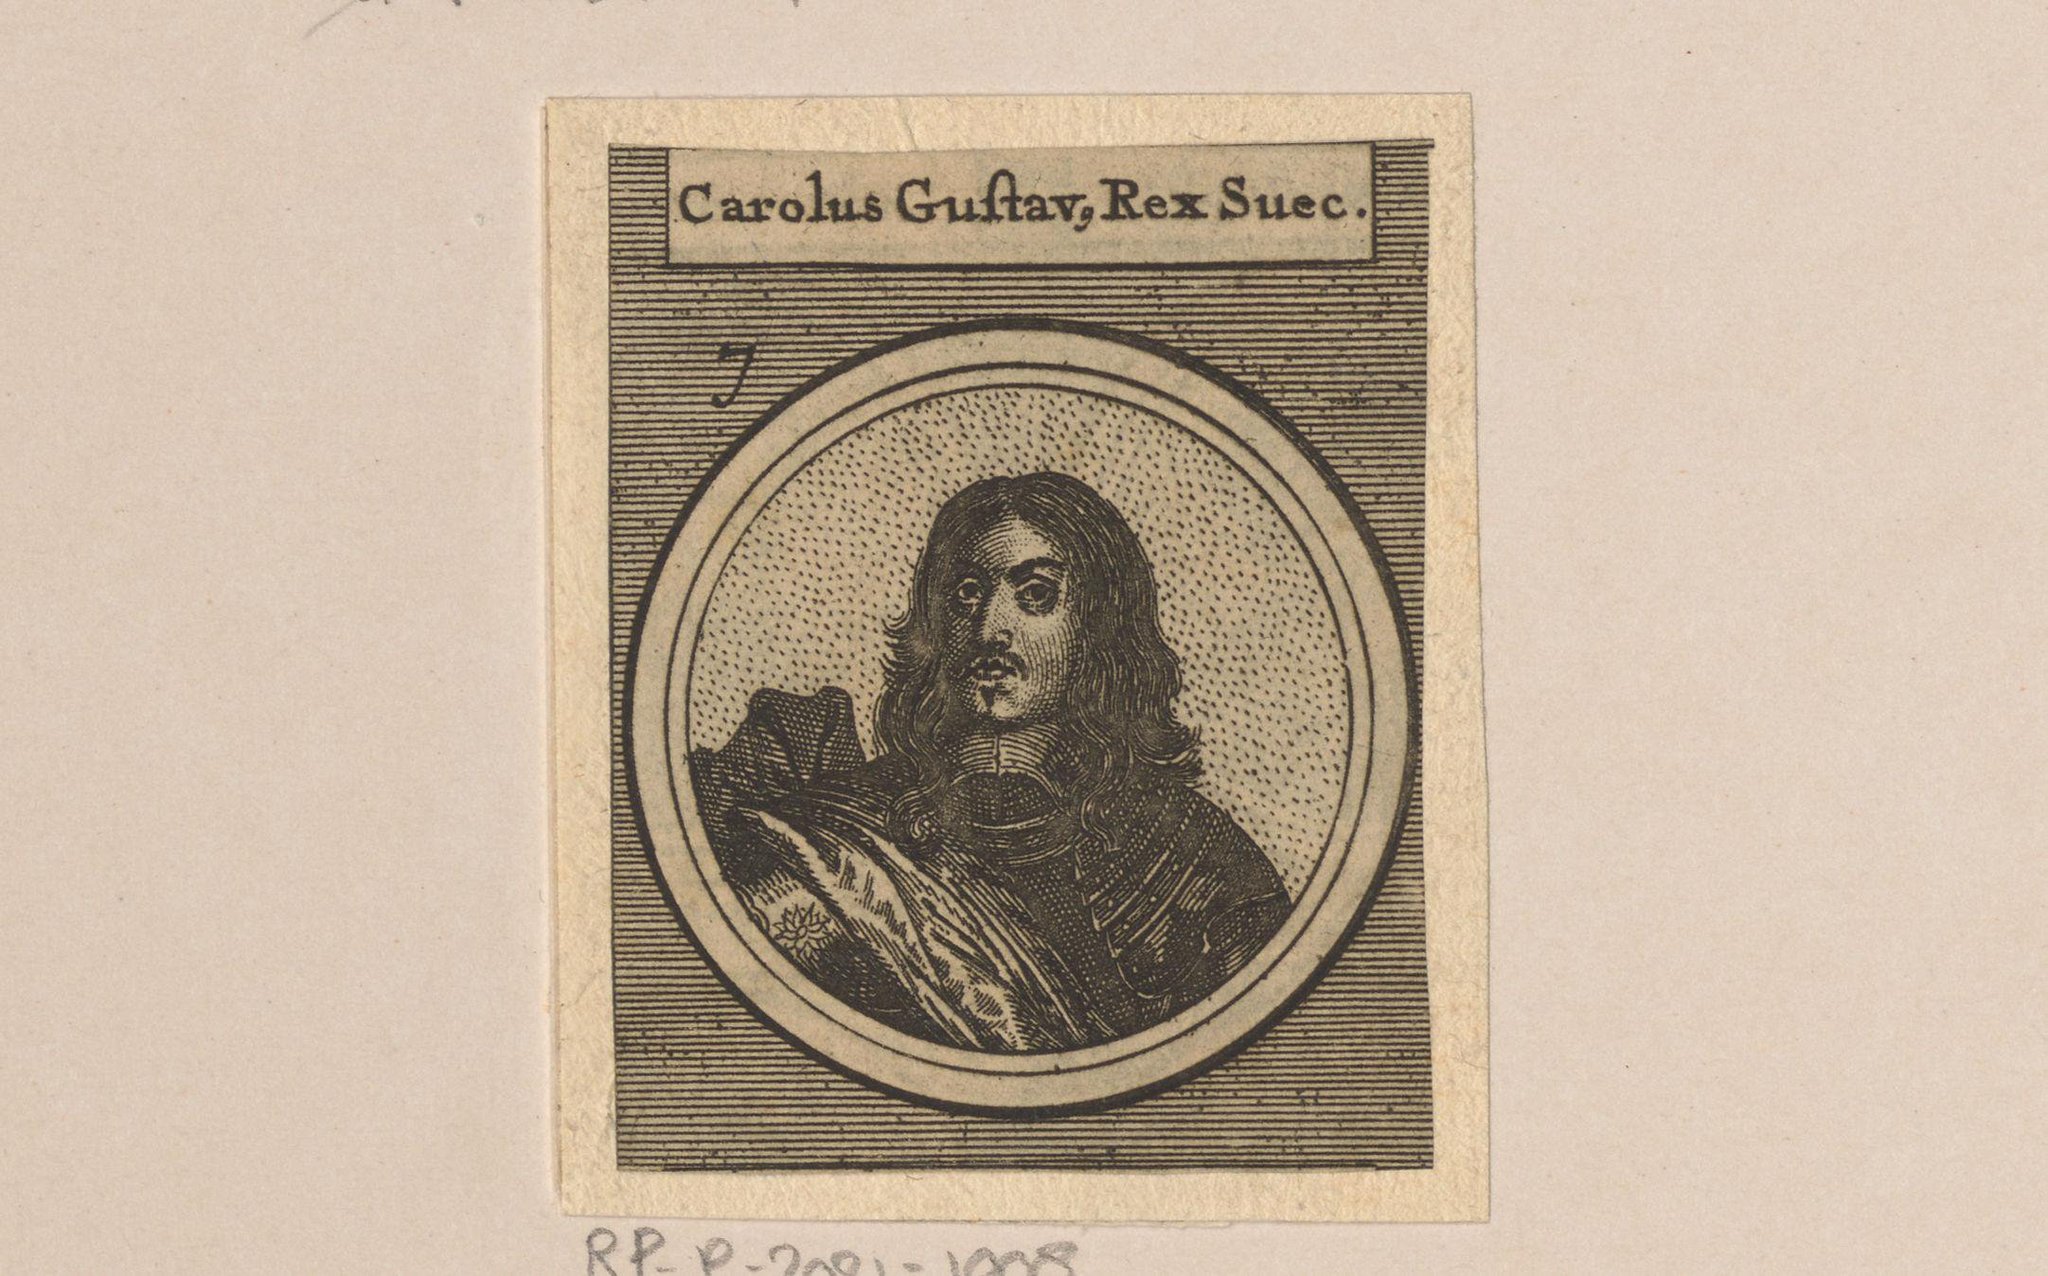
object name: book illustration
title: Portret van Karel X Gustaaf, koning van Zweden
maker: pieter van der aa (i)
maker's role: printer, publisher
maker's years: 1659-1733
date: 1698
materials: paper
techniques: engraving, etching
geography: leiden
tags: historical persons, king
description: De prent maakt onderdeel uit van een grotere prent met 24 portretten die later verknipt is. Prent uit: Gottfried, Johan Ludwig en Simon de Vries. Historische kronyck: vervattende een nauwkeurige en volkomene beschrijvingh der aldergedenck waerdiste geschiedenissen des weerelds (...). Leiden: Pieter van der Aa, 1698. Prent voor het eerst gebruikt in hetzelfde boek uitgegeven in Amsterdam door weduwe Joannes Brouwer en Jacobus van Meurs in 1660. Prent mogelijk ook gebruikt in latere edities.